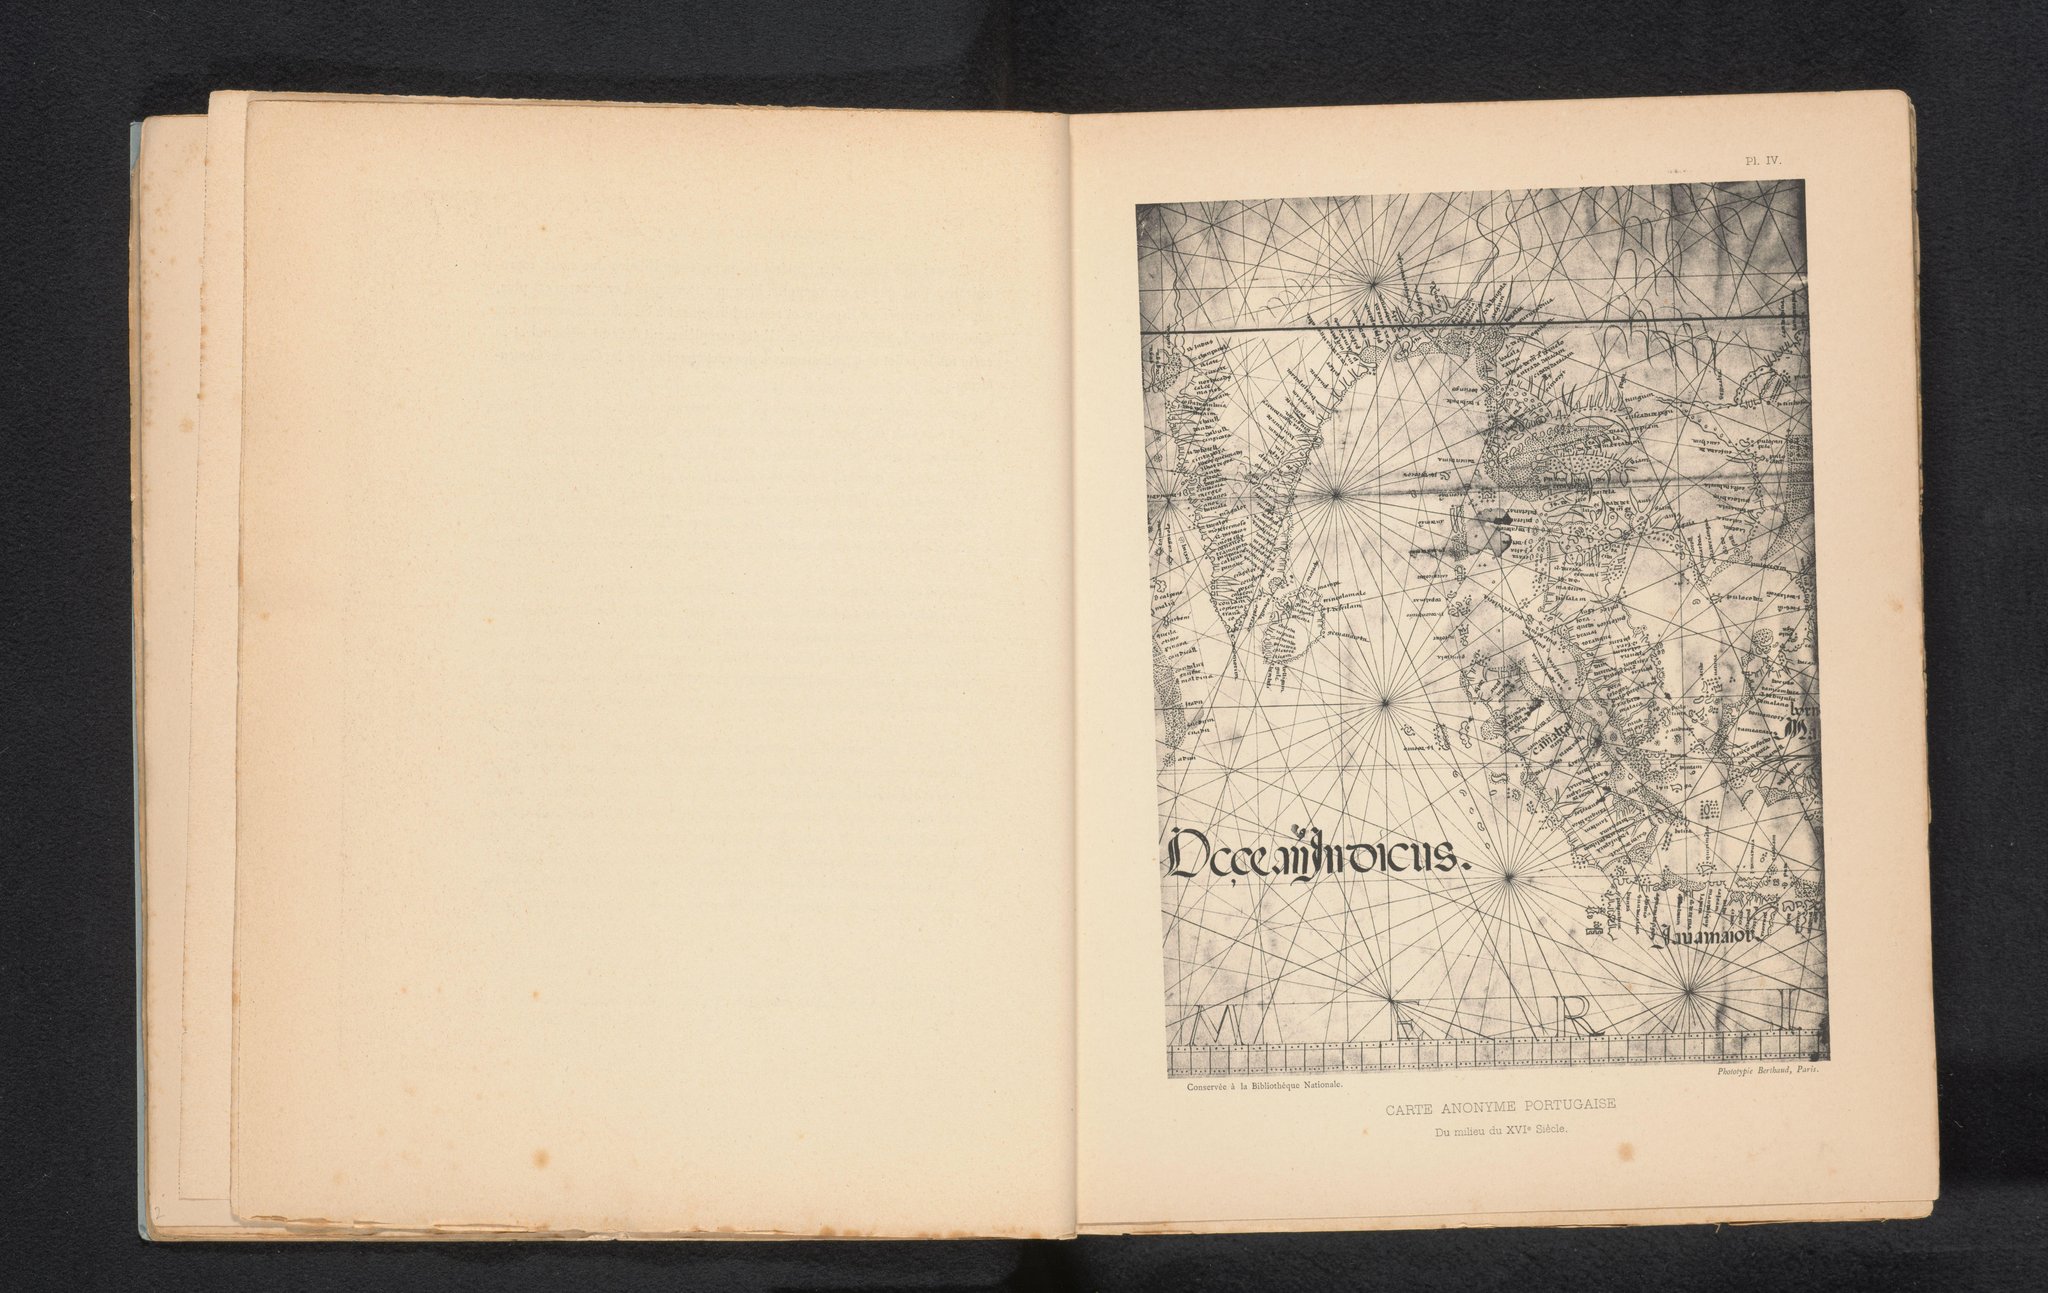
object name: reproduction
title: Reproductie van een landkaart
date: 1890-1895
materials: paper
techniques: photograph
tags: maps, atlases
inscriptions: collector's mark: ‘Société d'Emulation de l'Ain/ Bourg/ Bibliothèque’, inscription: ‘Pl. IV/ Conservée à la Bibliothèque Nationale’, inscription: ‘Du milieu du XVIe Siècle’